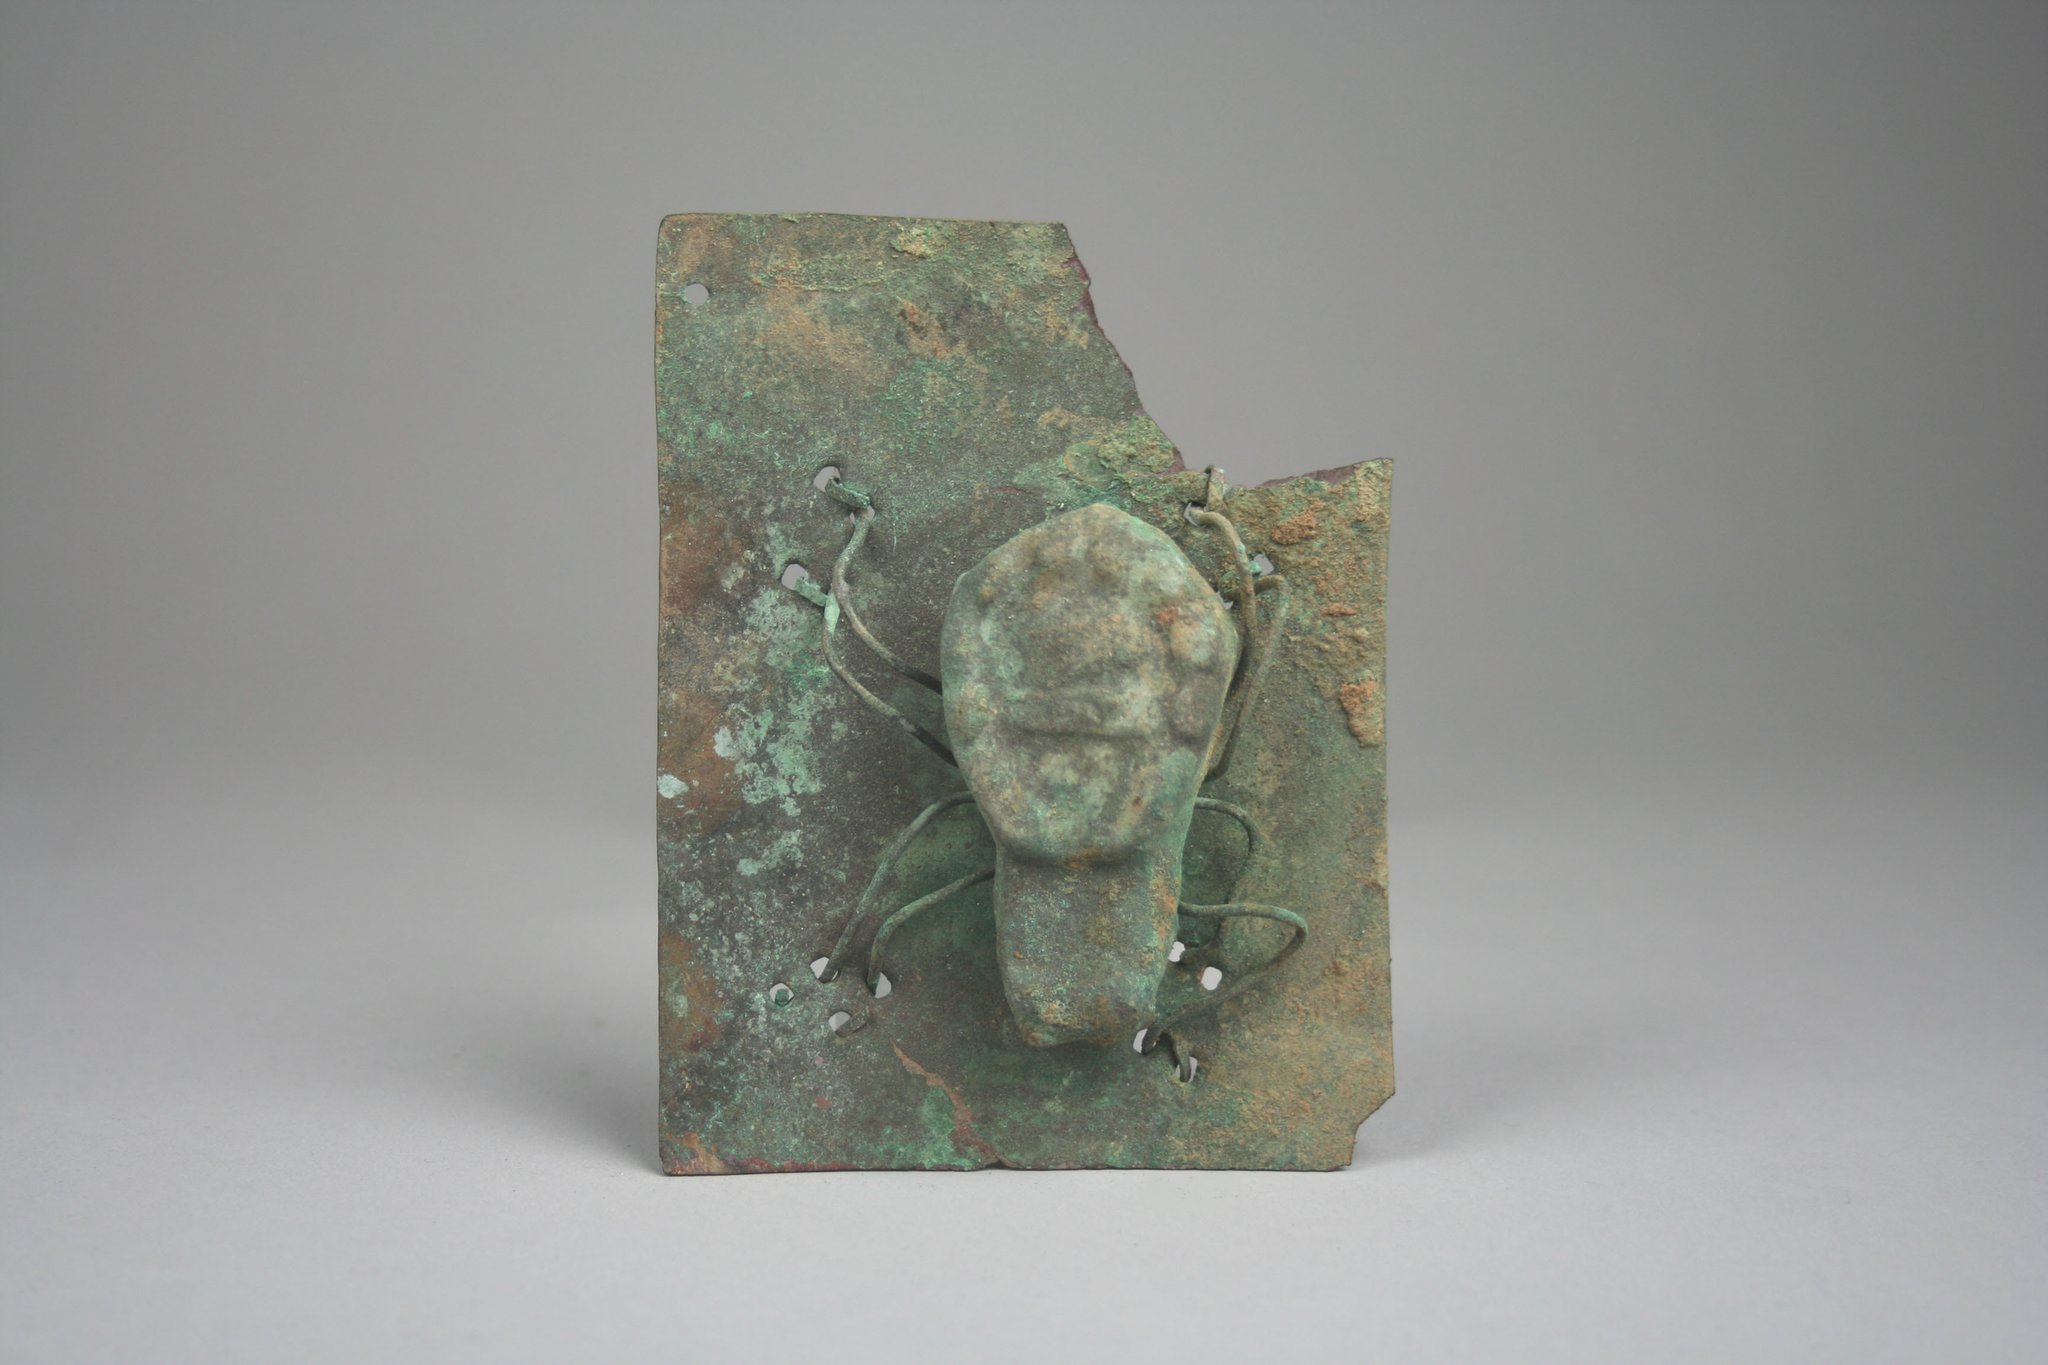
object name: ornament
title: Spider Ornament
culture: moche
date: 501-700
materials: metal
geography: peru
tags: insects